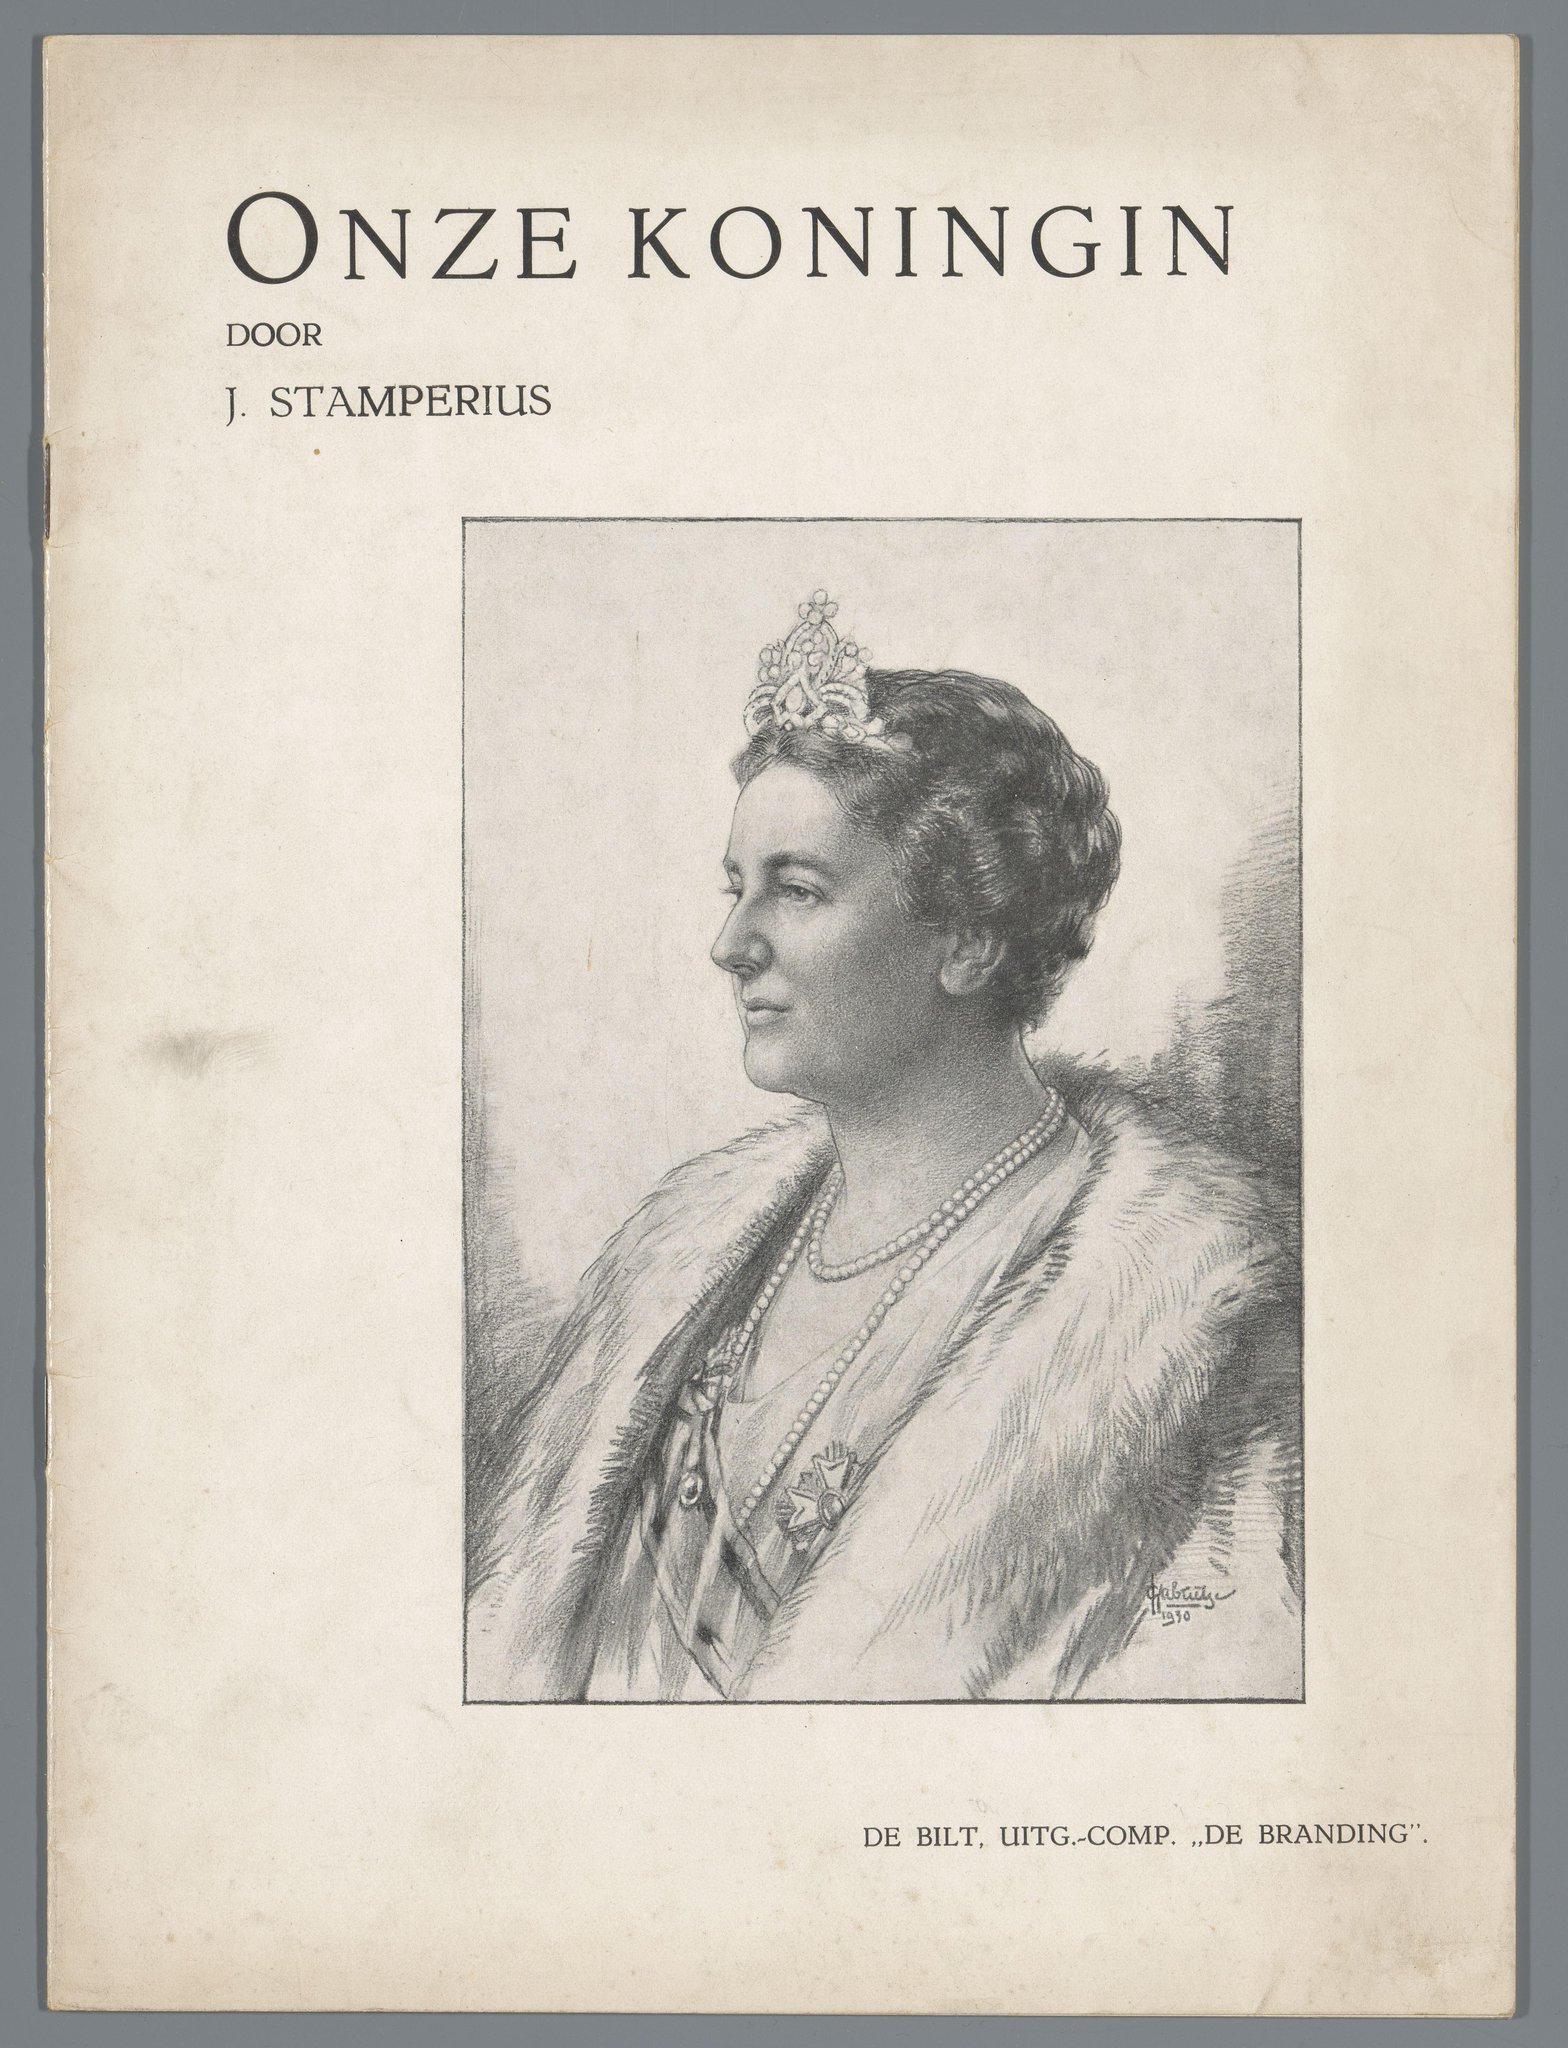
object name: brochure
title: Onze Koningin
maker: jacob stamperius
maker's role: schrijver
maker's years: 1858-1936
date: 1930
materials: paper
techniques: printing, stapling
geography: de bilt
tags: the hague, print maker, wilhelmina of the netherlands, netherlands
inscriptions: date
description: 22 pp op glanspapier in papieren omslag. Gedateerd; titelp.: 1930.